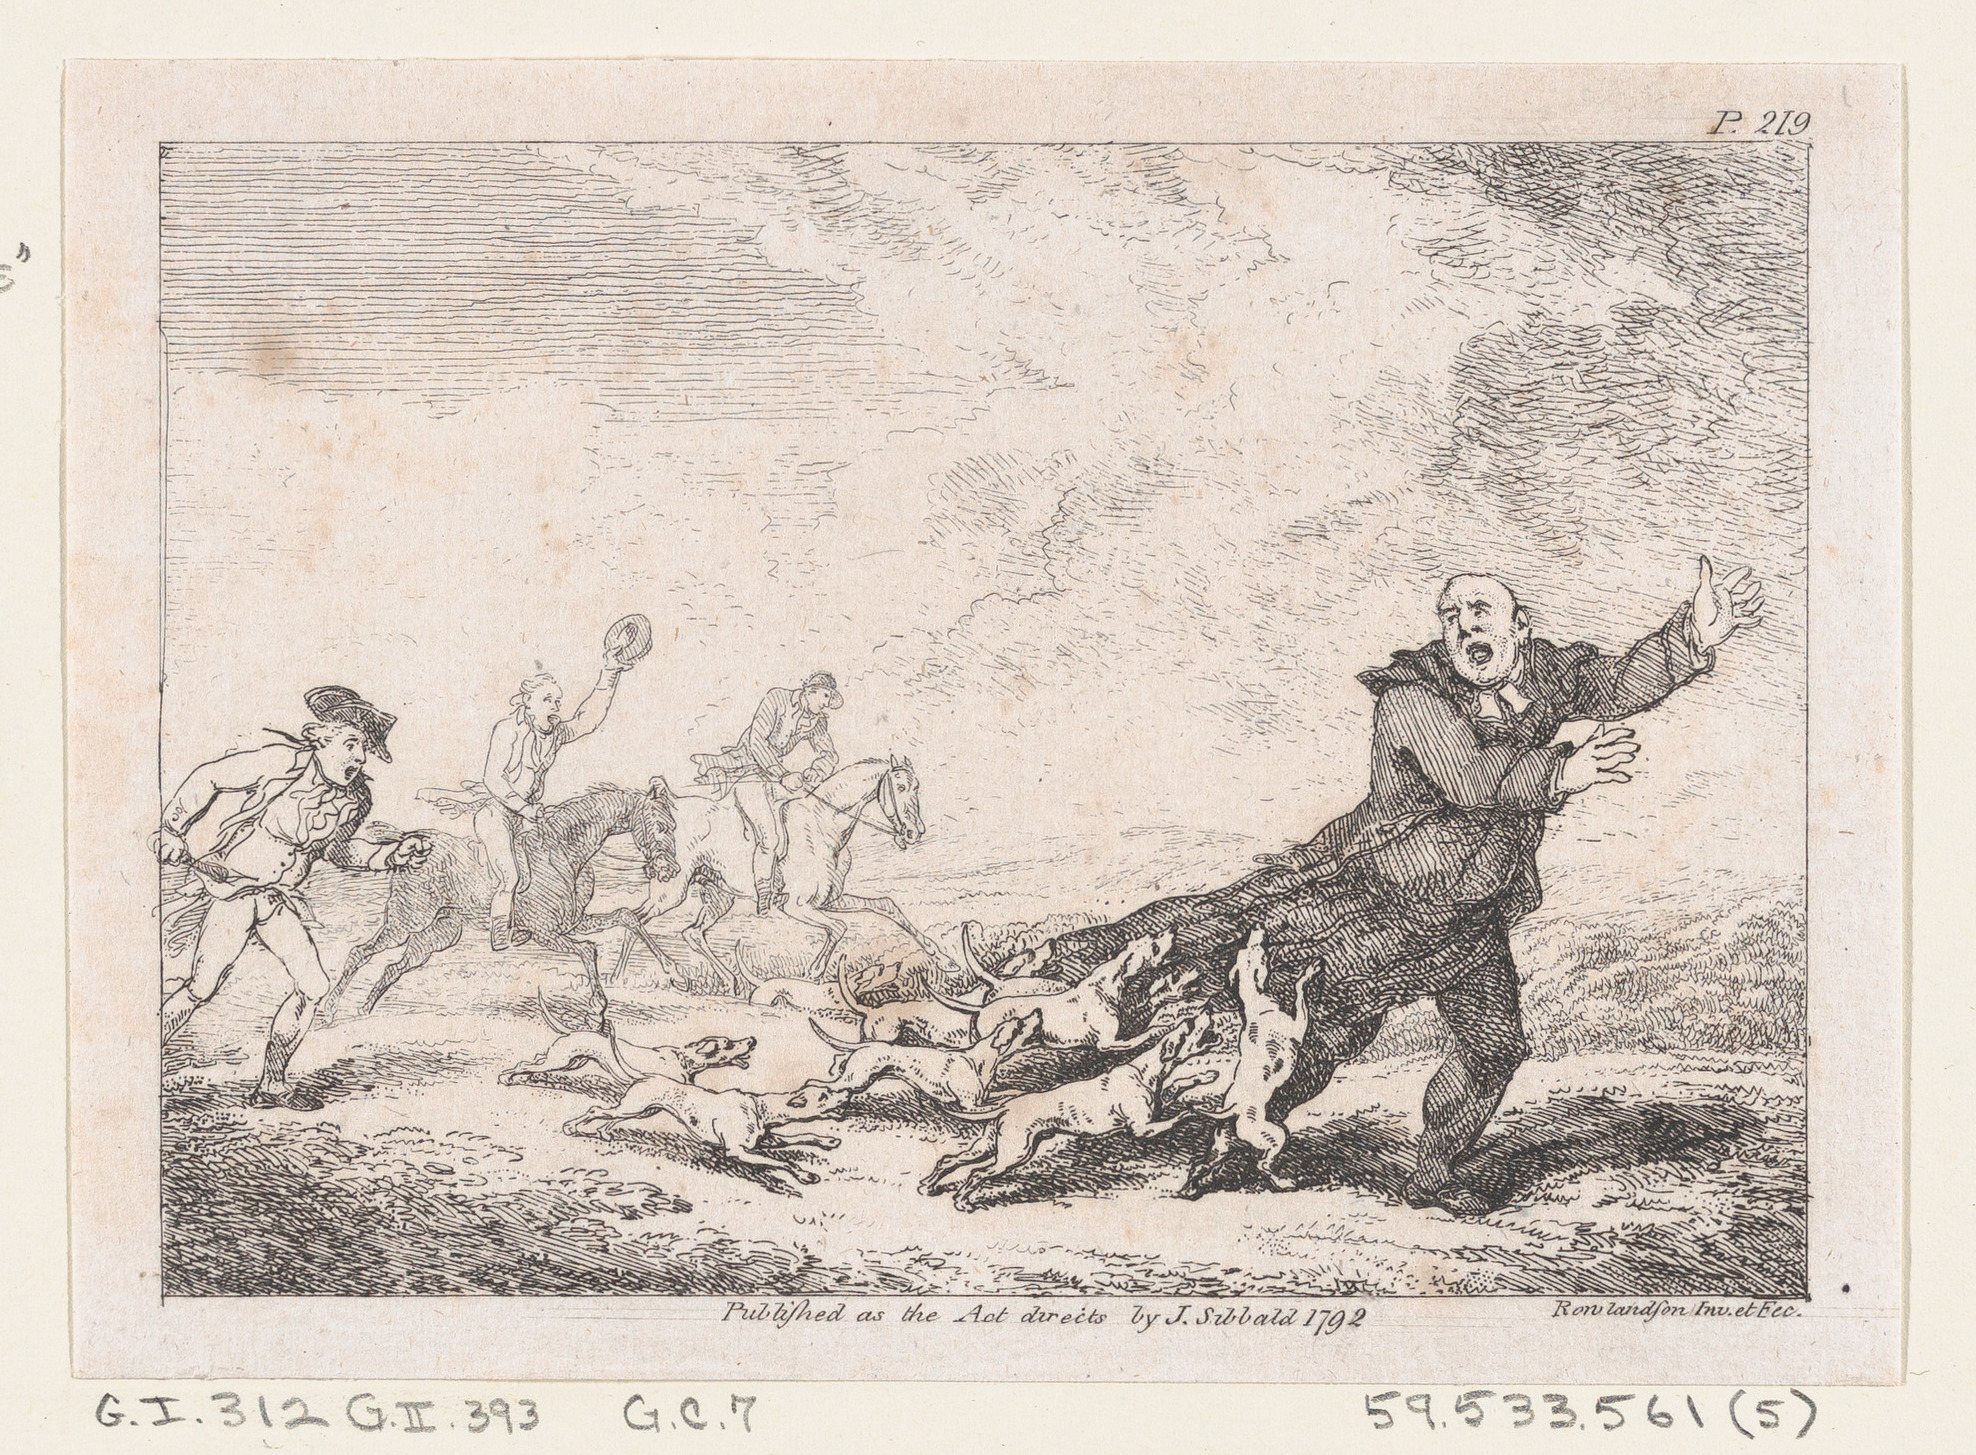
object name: print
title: Parson Adams Engaged In A Perilous Hunting Adventure, from "The Adventures of Joseph Andrews, and his friend Mr. Abraham Adams"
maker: thomas rowlandson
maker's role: artist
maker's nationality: british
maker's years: 1757-1827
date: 1792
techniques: etching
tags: fear,men,hunting,dogs,horses